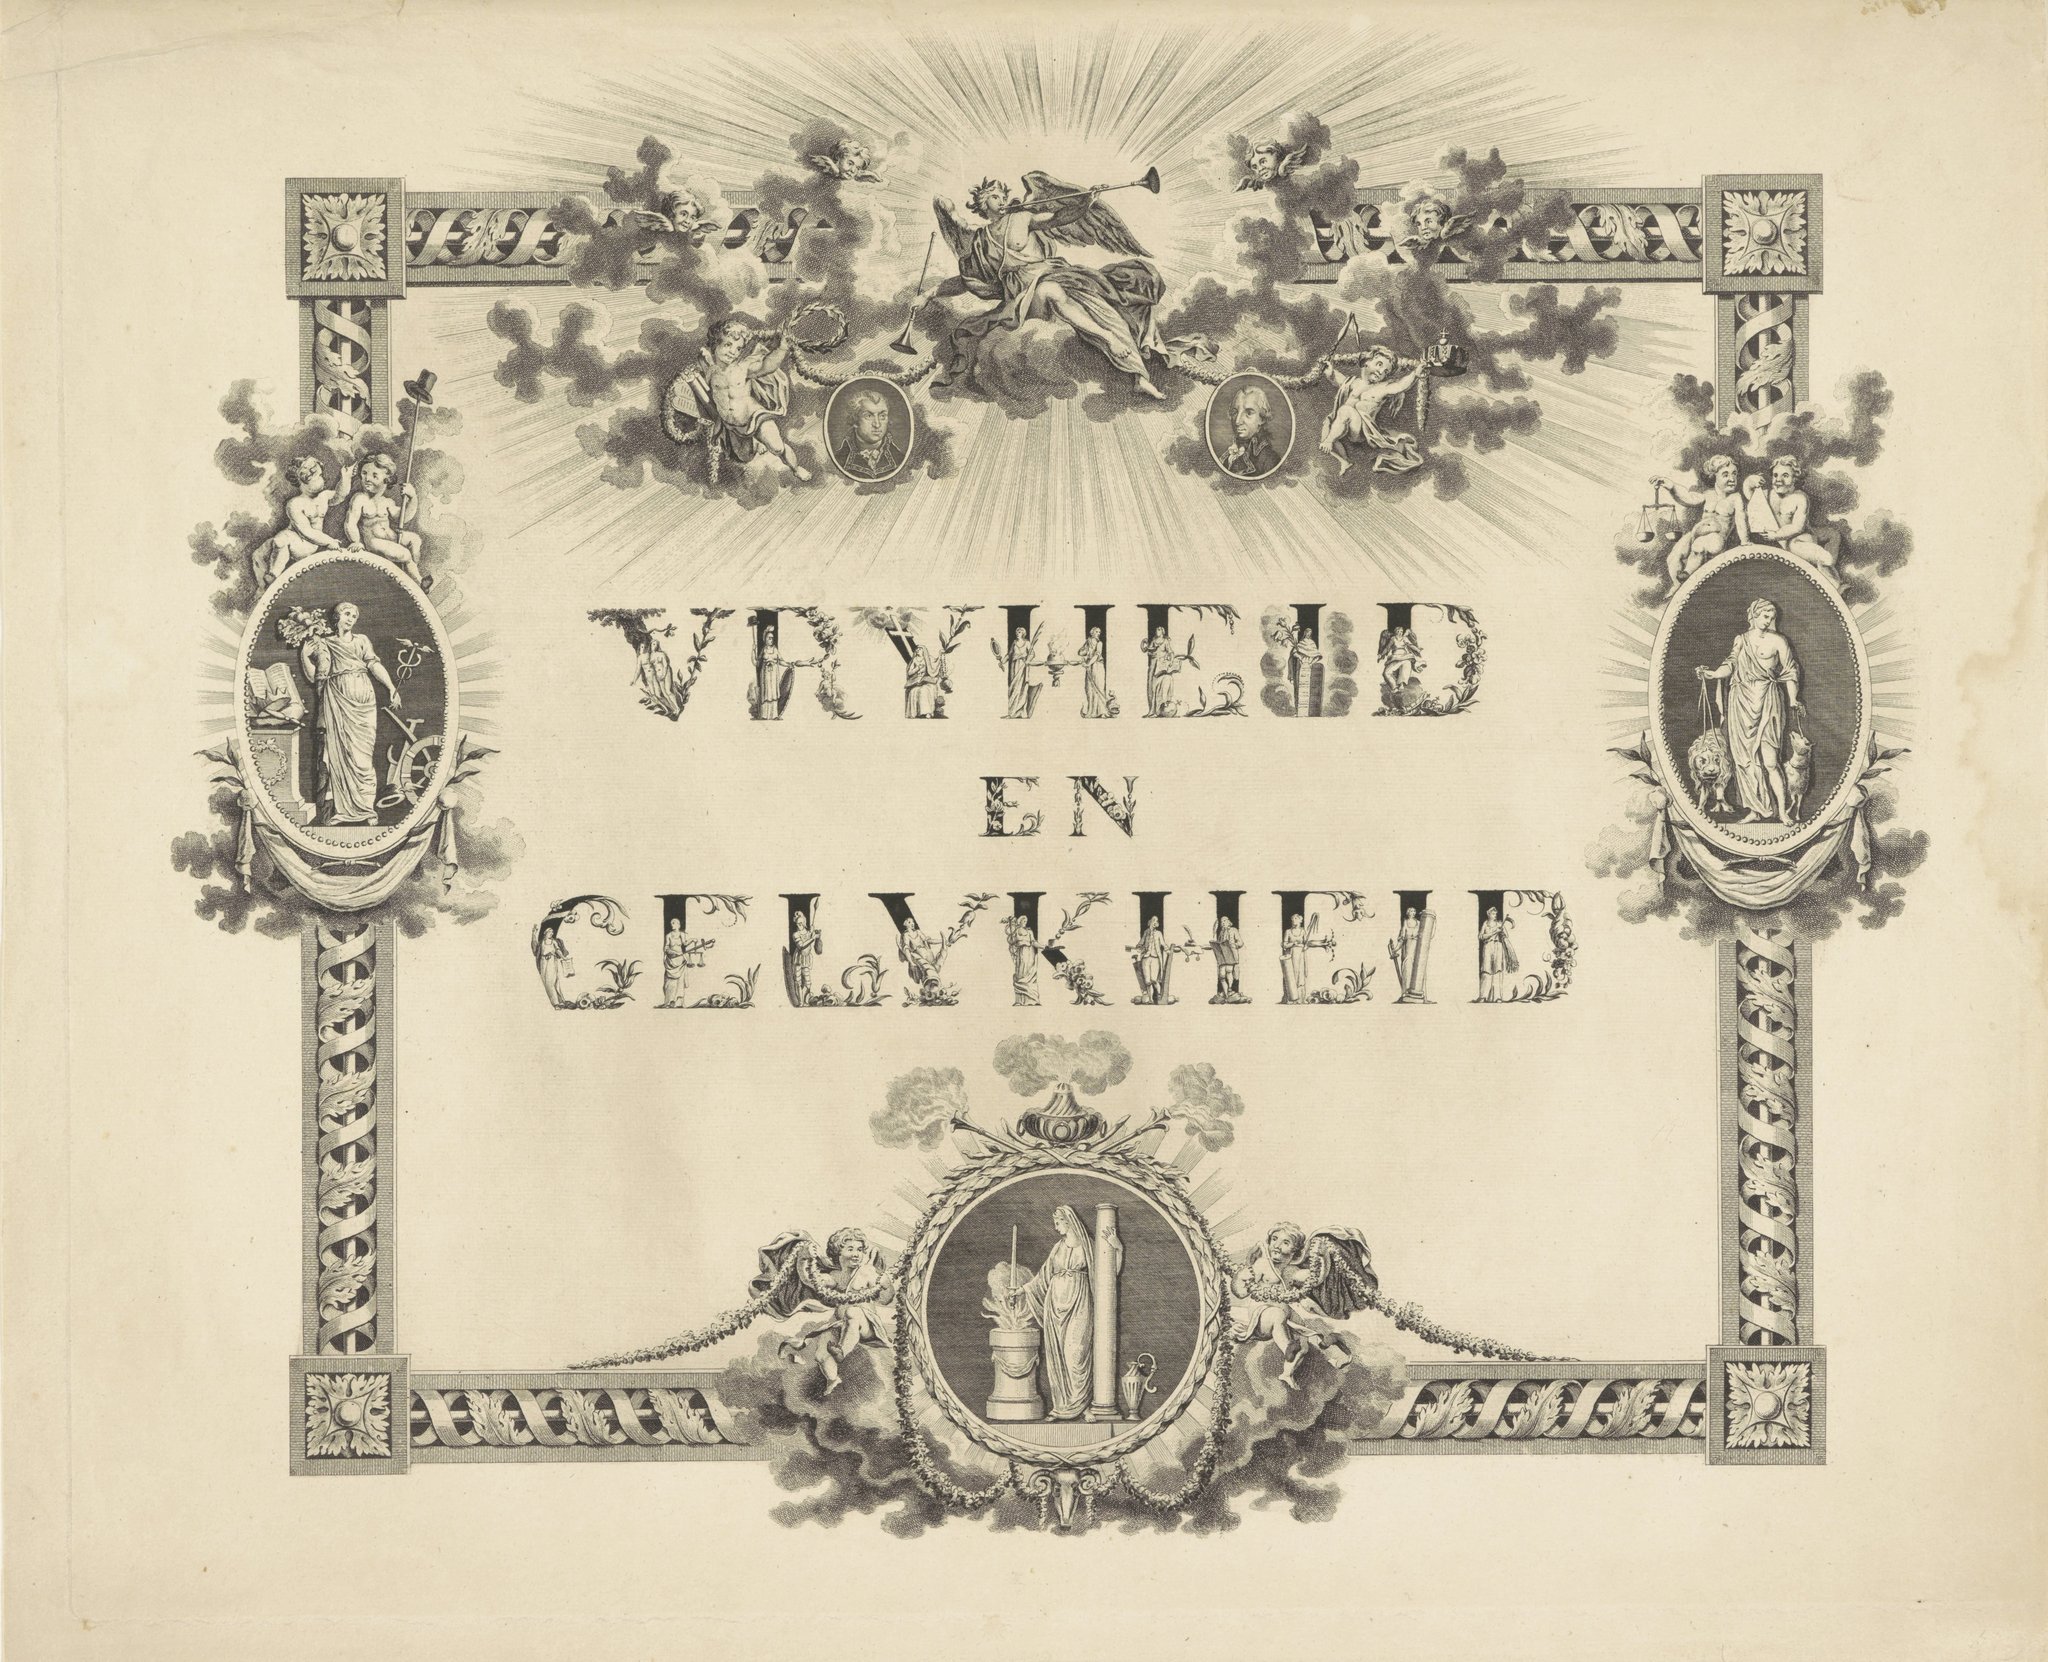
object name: print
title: Vryheid en Gelykheid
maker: Anonymous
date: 1795-1796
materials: paper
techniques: engraving, etching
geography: netherlands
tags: paris, politician, jean-charles pichegru, herman willem daendels, fame; 'fama', 'fama buona', 'fama chiara' (ripa)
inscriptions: collector's mark: Lugt 2228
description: Allegorie op de Vrijheid en Gelijkheid, 1795. Opschrift in calligrafische letters, gevormd door staande mannen en vrouwen. Bovenaan blaast stralende Faam op haar bazuin bij de portretten van Daendels en Pichegru. Aan zijkanten en onderaan medaillons met allegorische figuren.